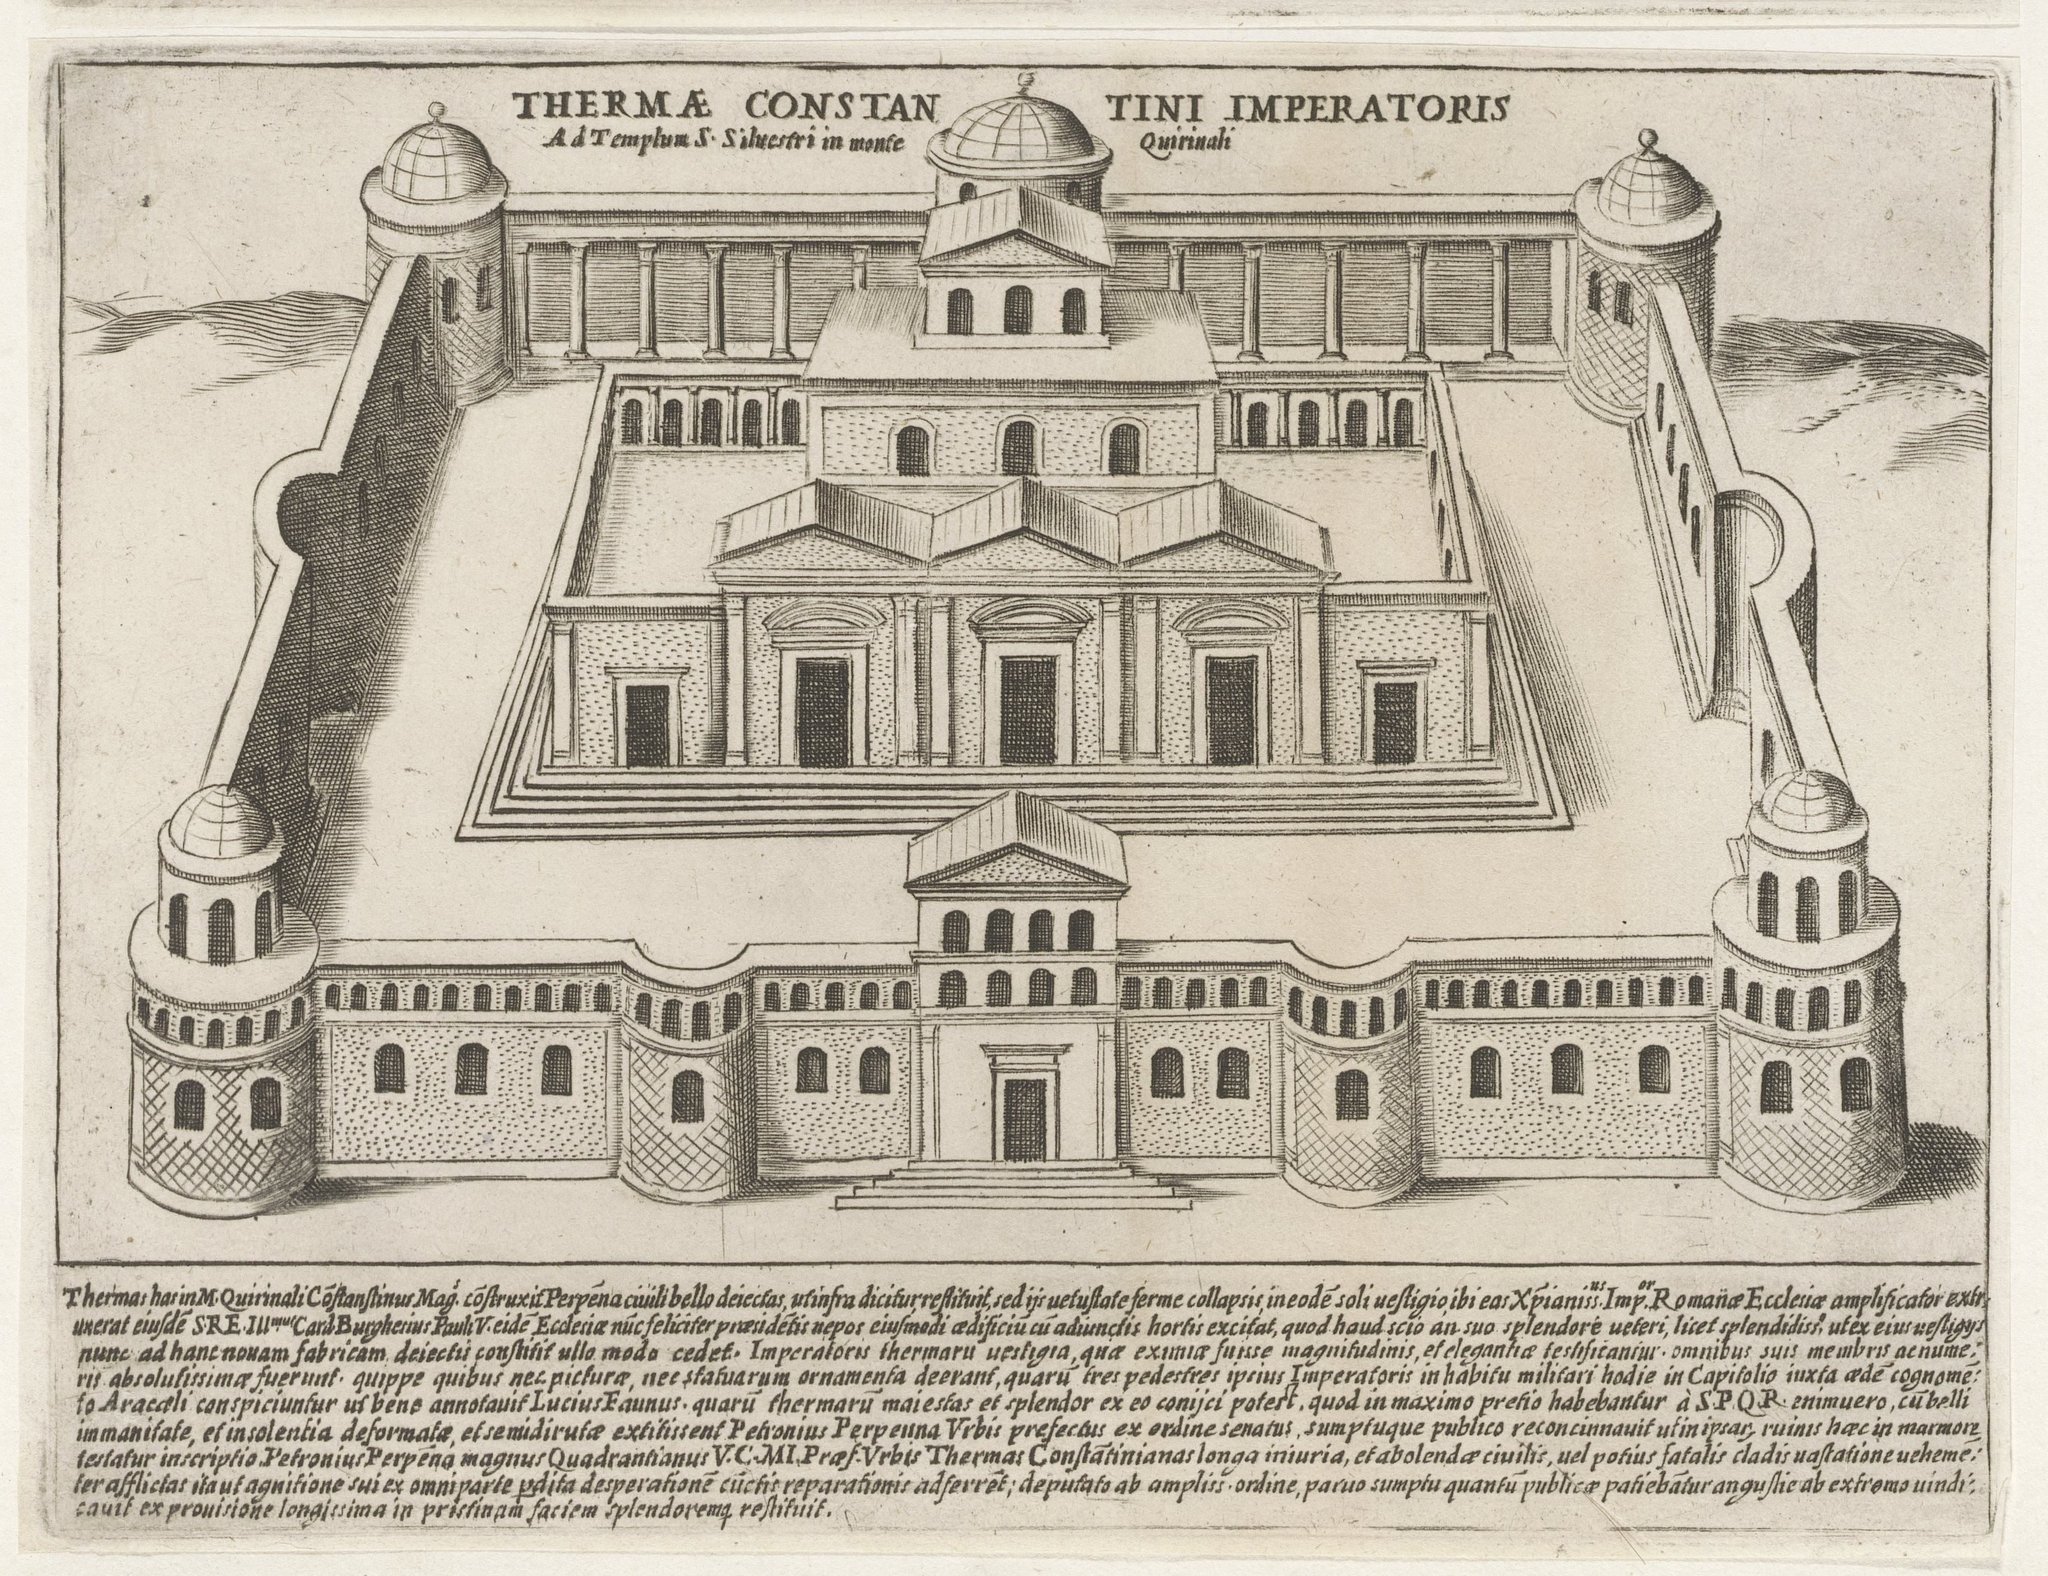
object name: print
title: Magesyn der Italiaense gebouwen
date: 1612-1628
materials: paper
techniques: etching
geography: rome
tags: public baths, representation of real building (either existing or having existed)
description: Deze prent maakt deel uit van een set van 158 prenten (+ titelprenten), die verscheen in vier delen. In 1612 verschenen delen één en twee. In 1615 verscheen het derde deel en in 1628 verscheen deel vier. In 1637 publiceerde Vitale Mascardi de eerste heruitgave van de gehele set met nummering.